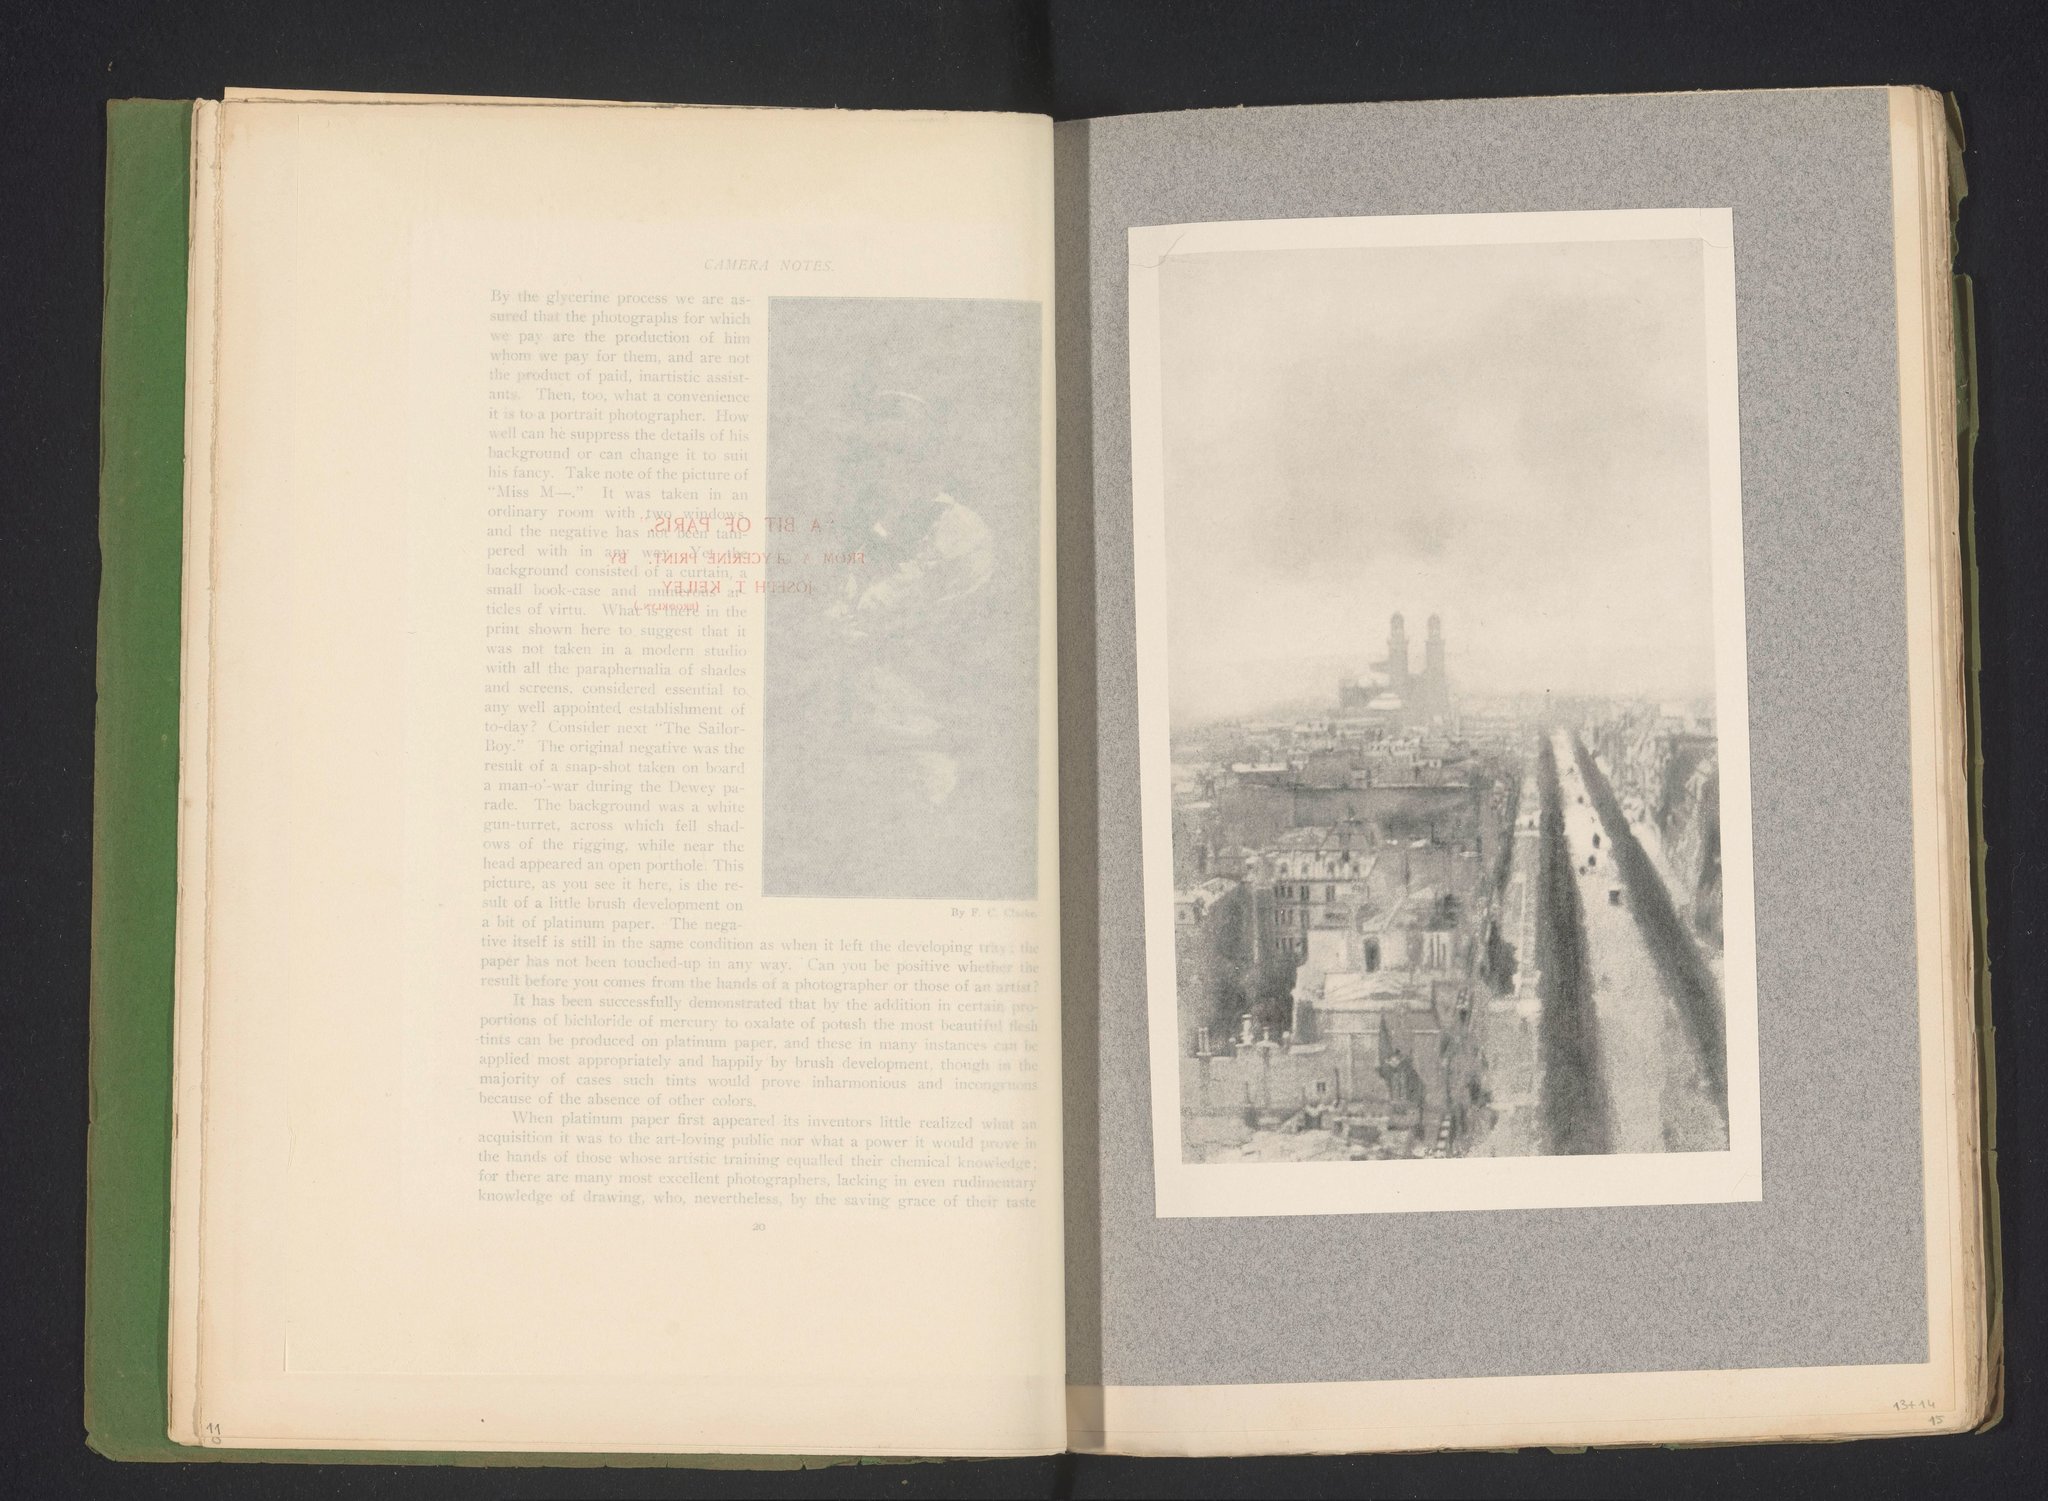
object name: photomechanical print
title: Gezicht op Parijs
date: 1896-1901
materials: paper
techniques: autotype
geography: paris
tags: prospect of city, town panorama, silhouette of city, paris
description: Prent tegenover pagina 20, achter semi-transparante omslag.